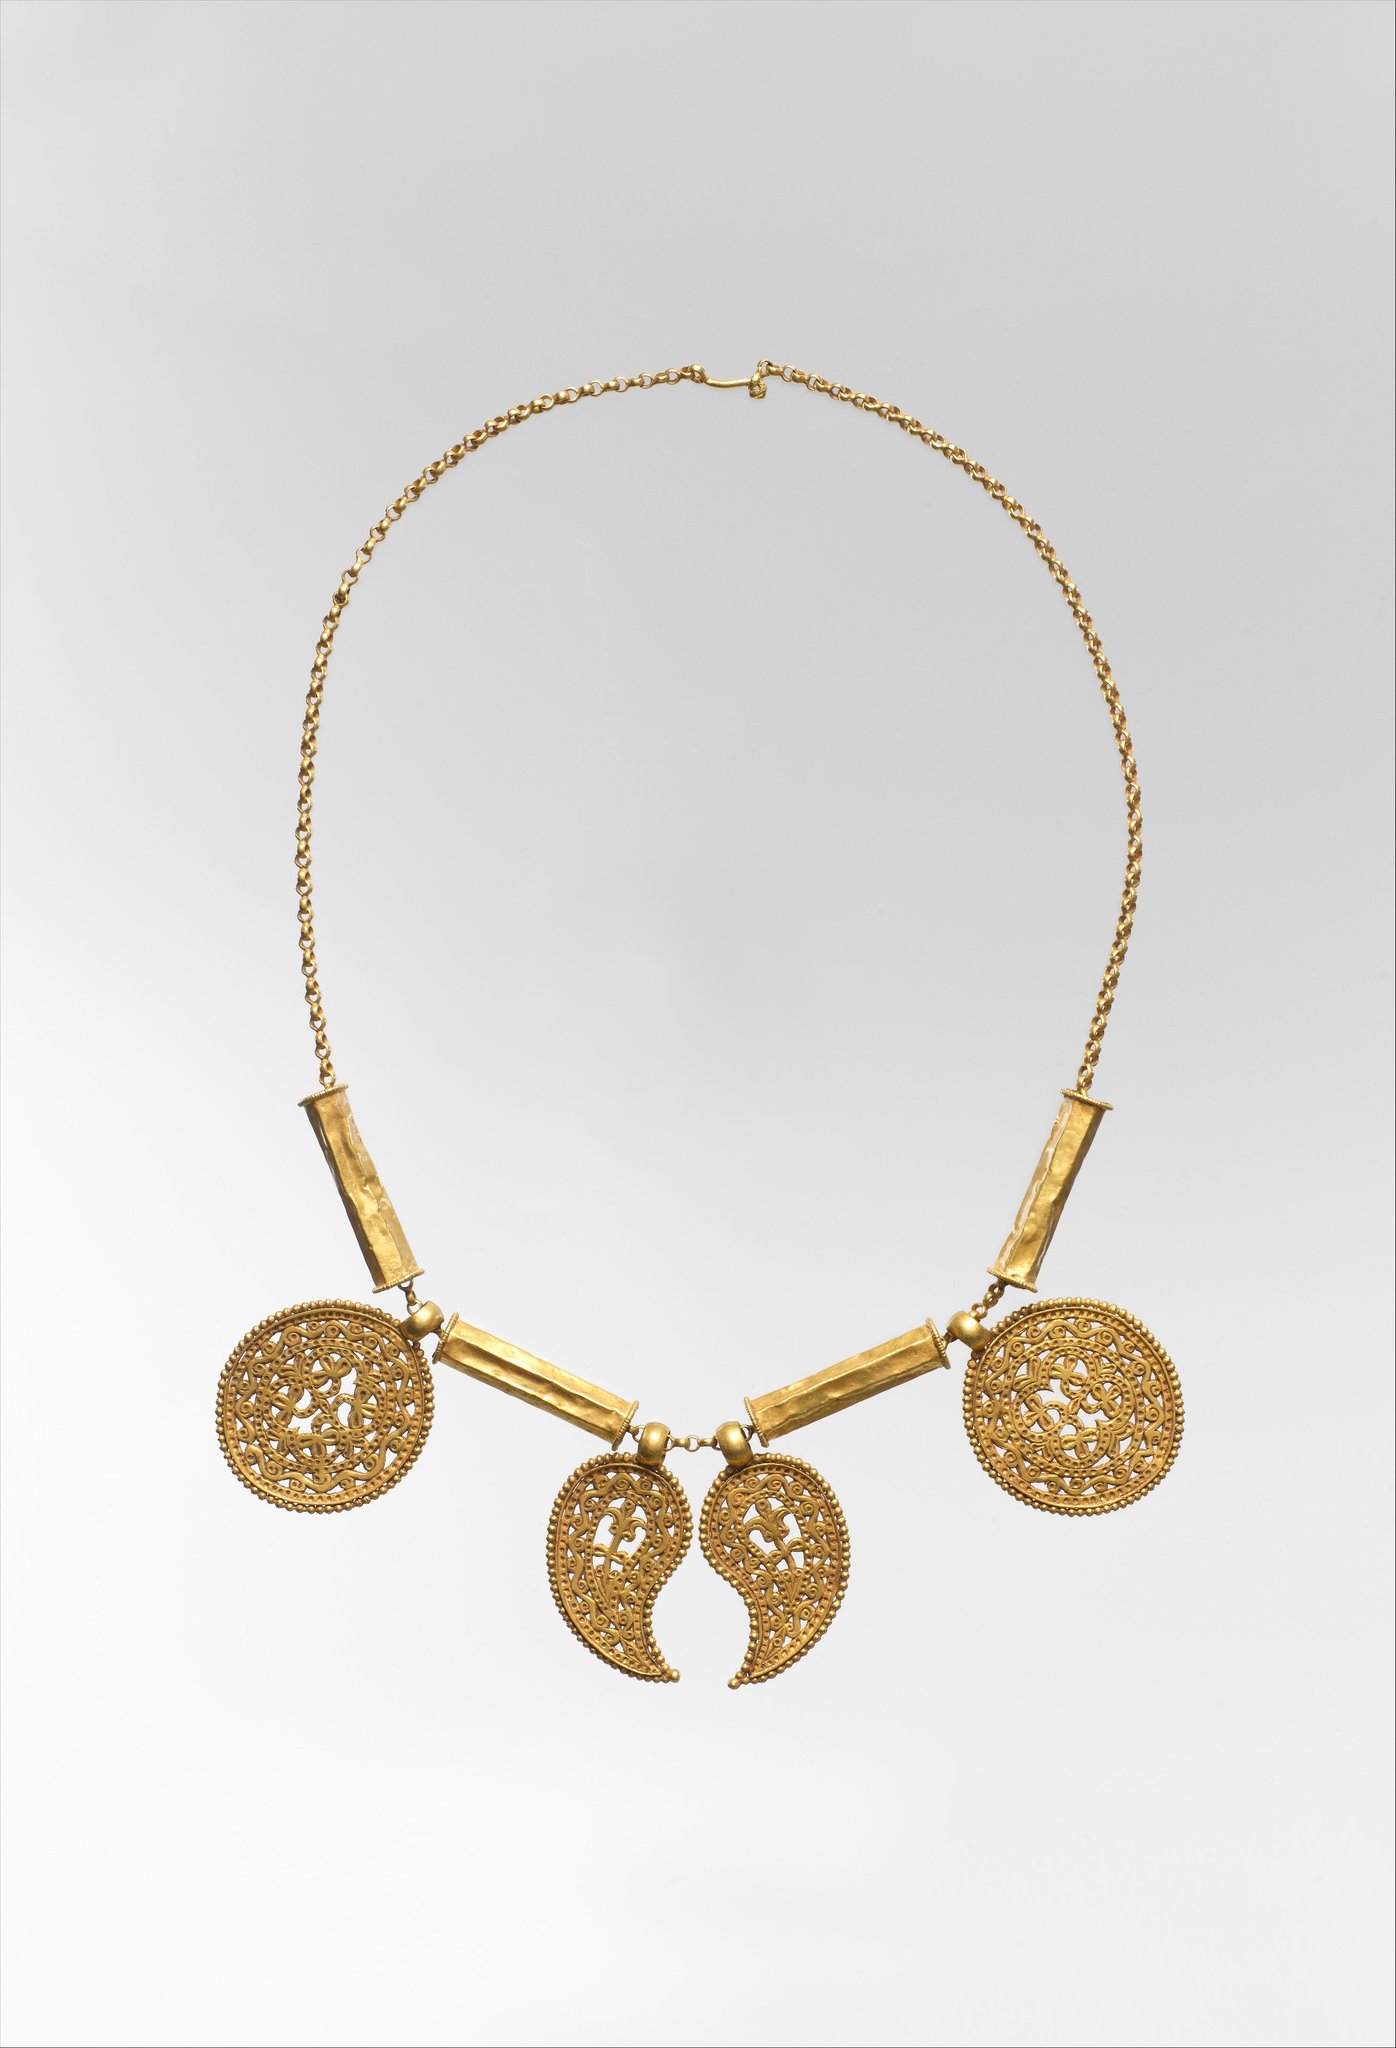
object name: necklace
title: Gold Necklace with Pendants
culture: byzantine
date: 601-700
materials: gold, metal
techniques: chasing, engraving